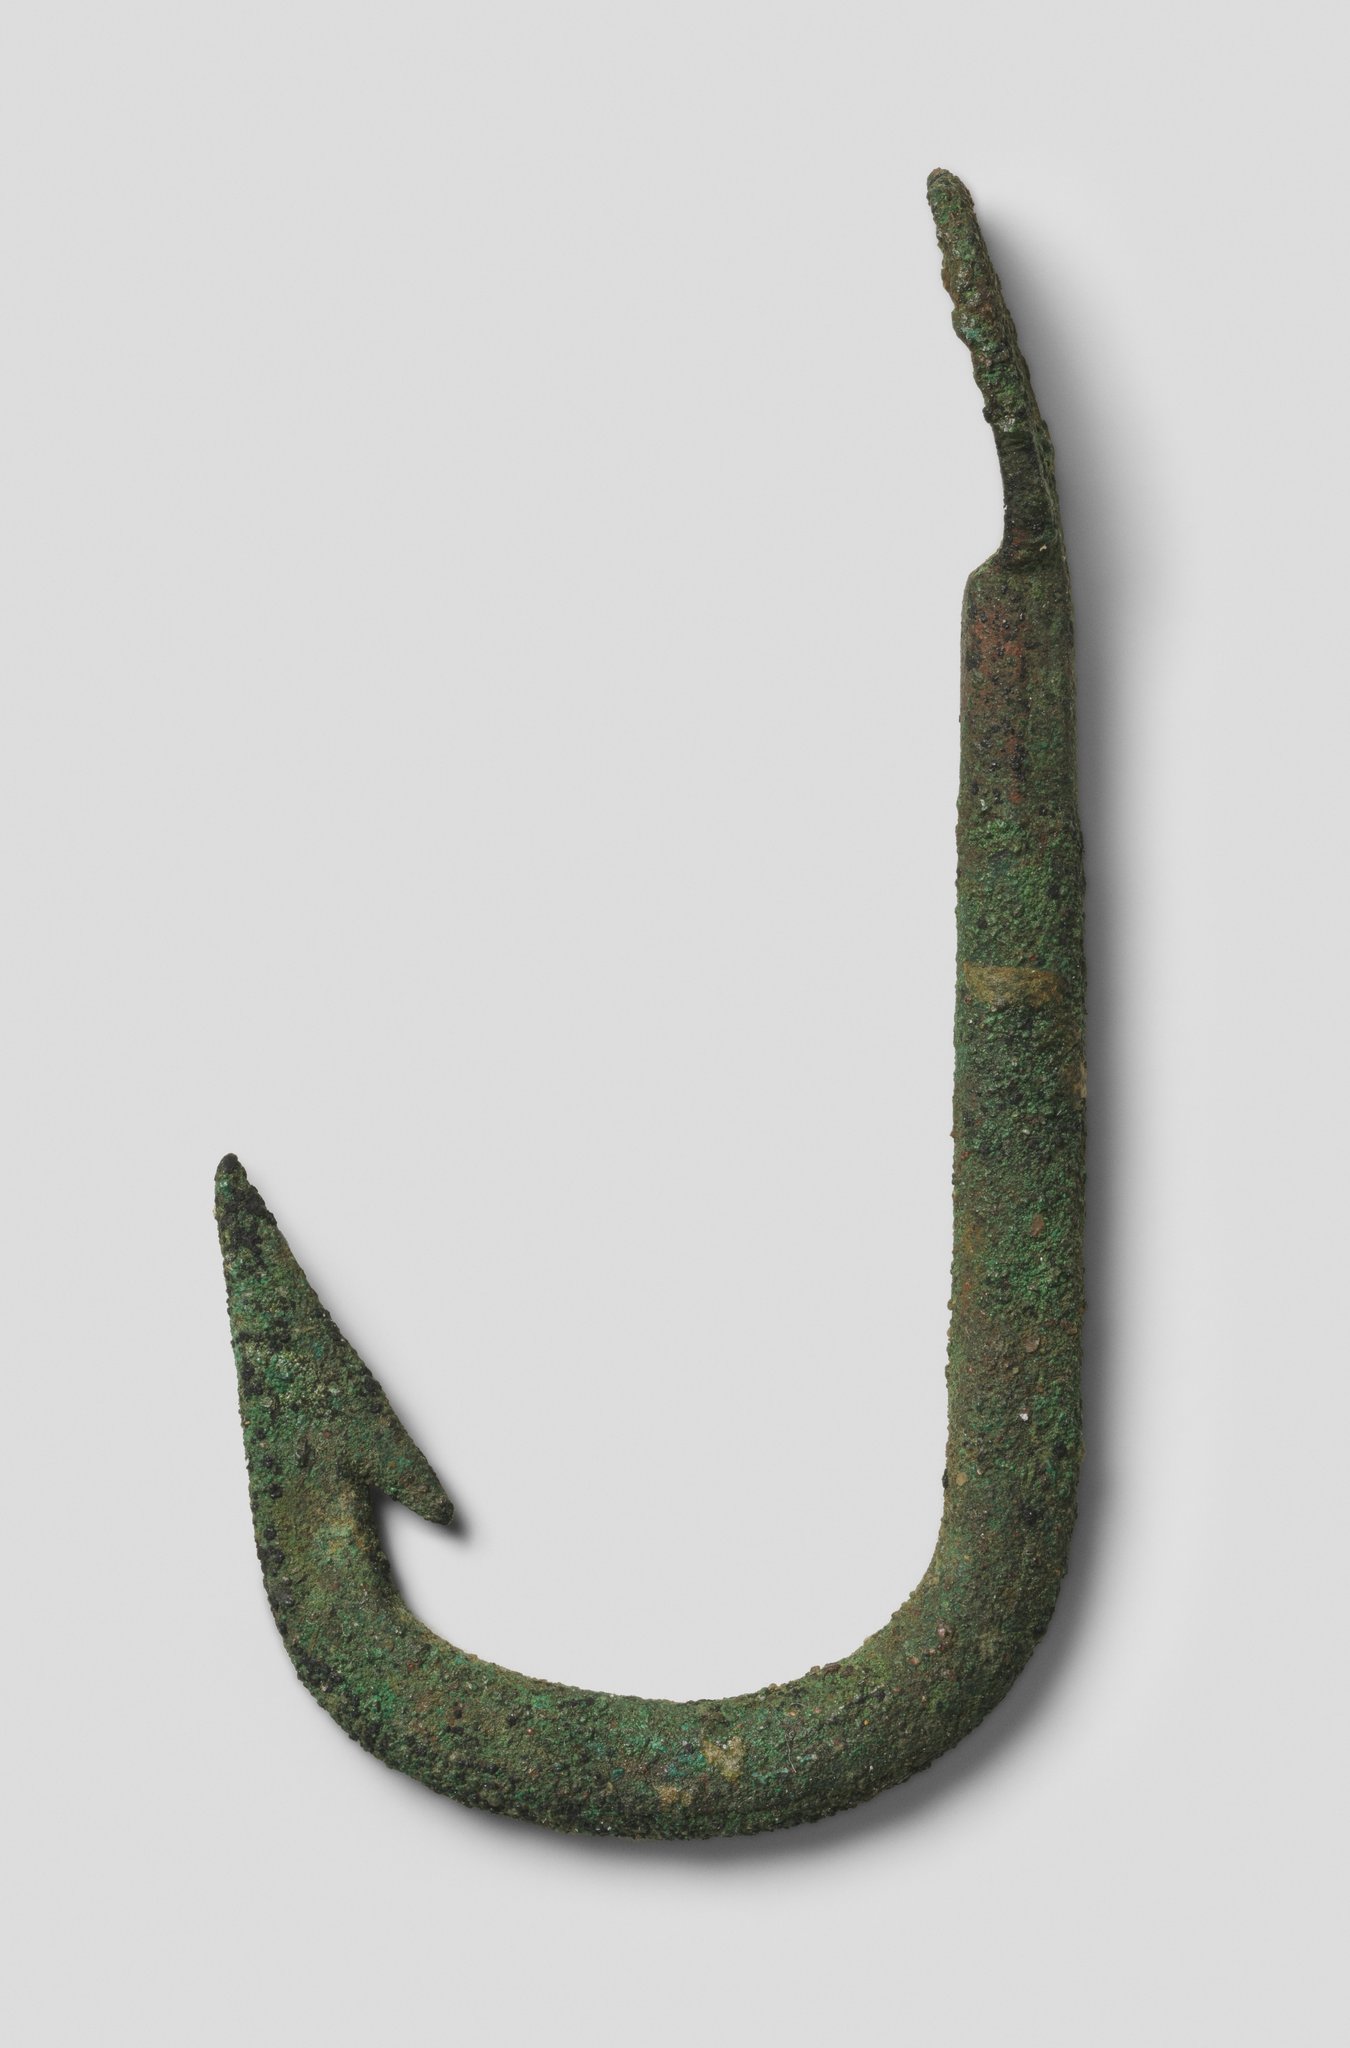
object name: fish hook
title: Barbed fishhook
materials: copper alloy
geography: egypt